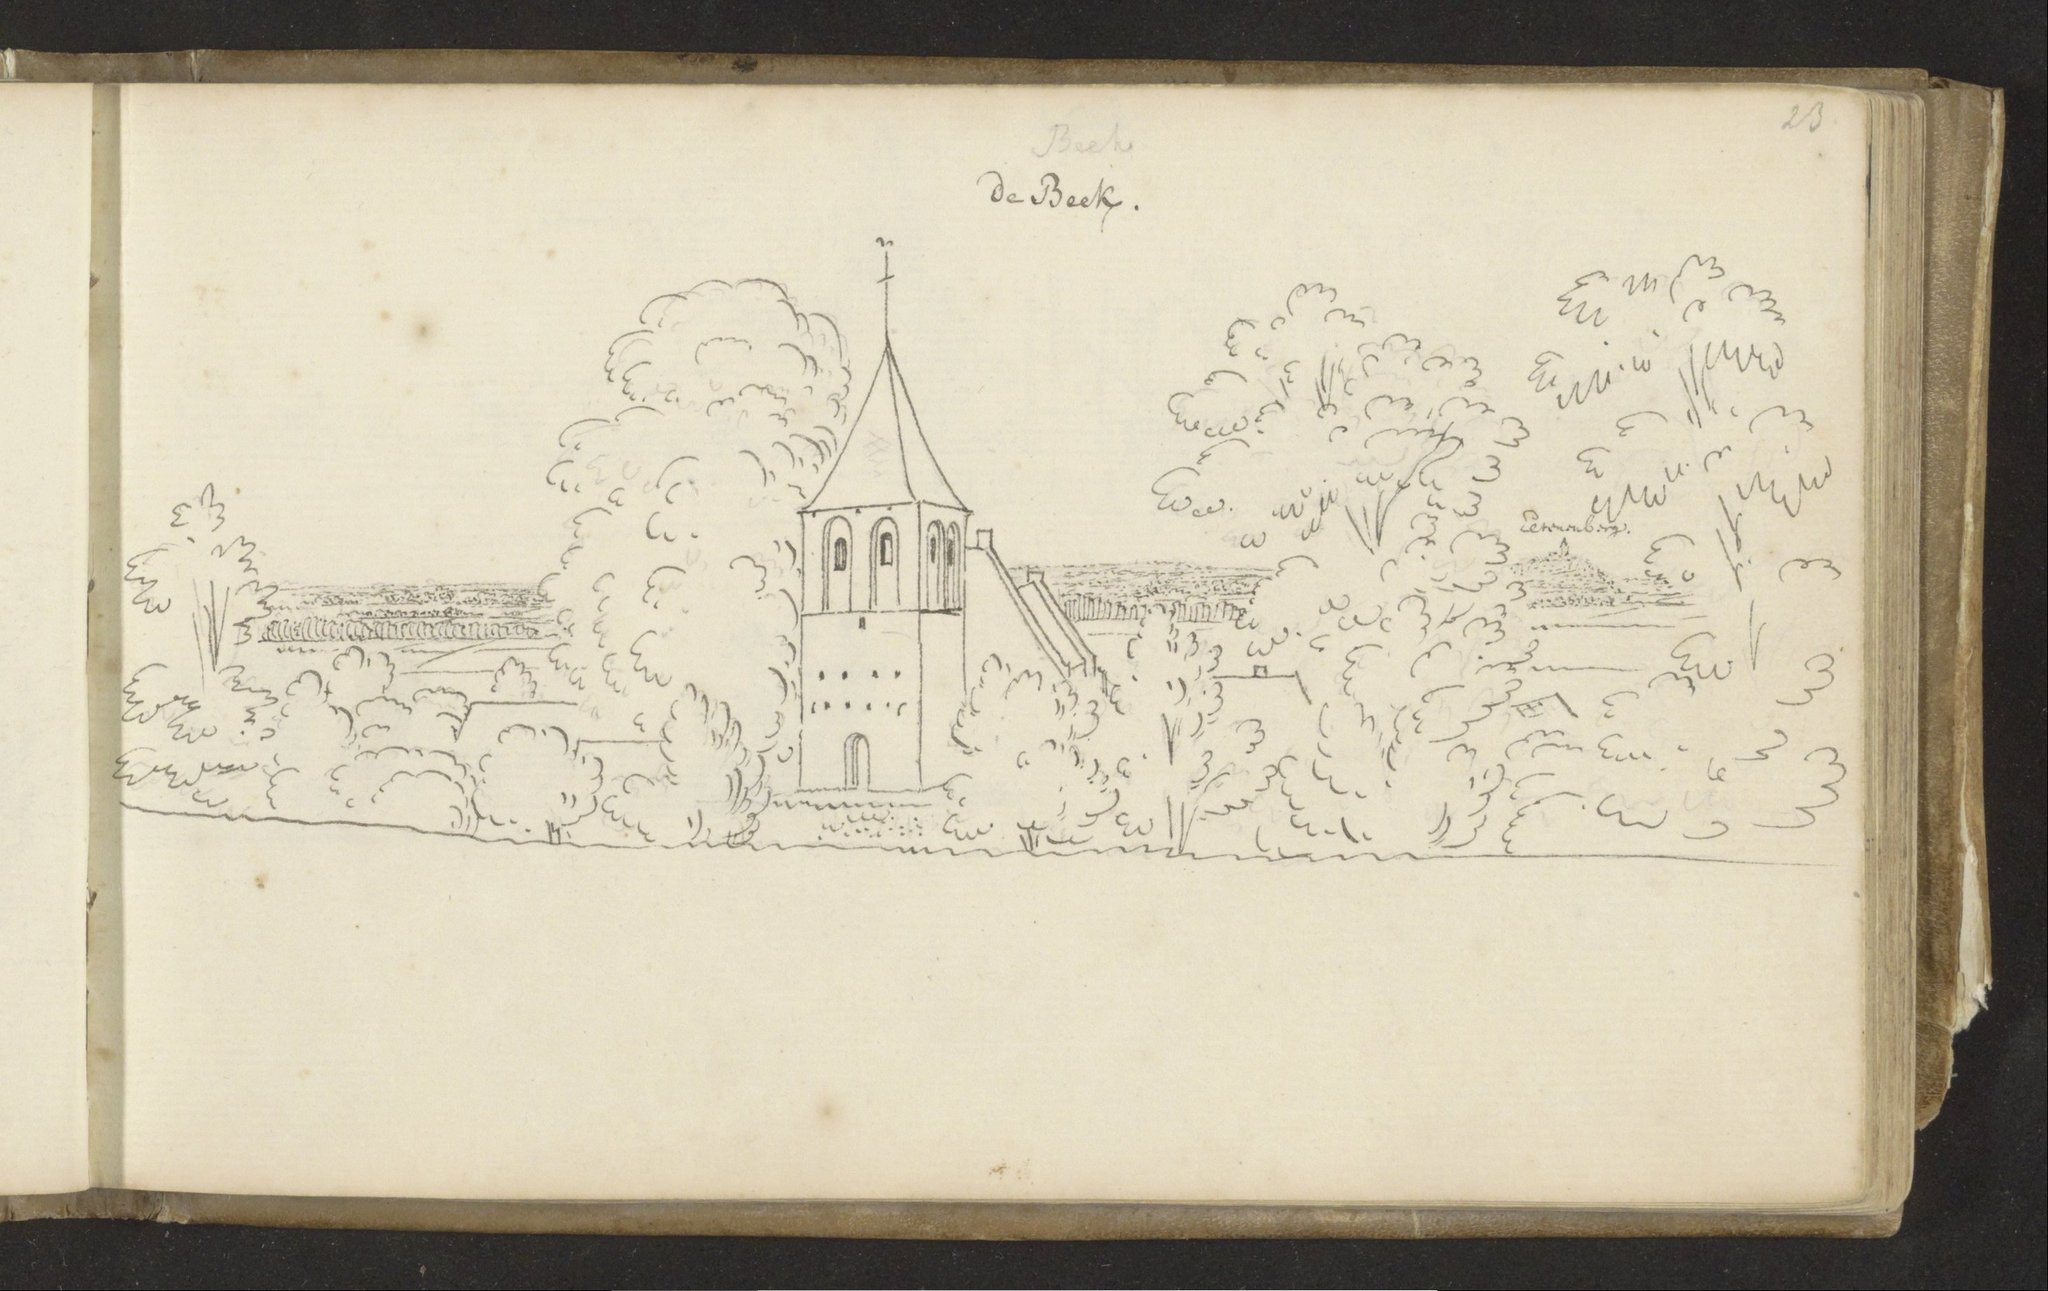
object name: sketchbook leaf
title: Dorpsgezicht te Beek met kerk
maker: abraham de haen (ii)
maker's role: draughtsman, print maker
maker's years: 1707-1748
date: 1731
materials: ink, paper, pencil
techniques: pen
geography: beek ubbergen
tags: village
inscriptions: annotation: ‘Beek/ de Beek’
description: Blad 23 recto uit een schetsboek met 69 bladen.